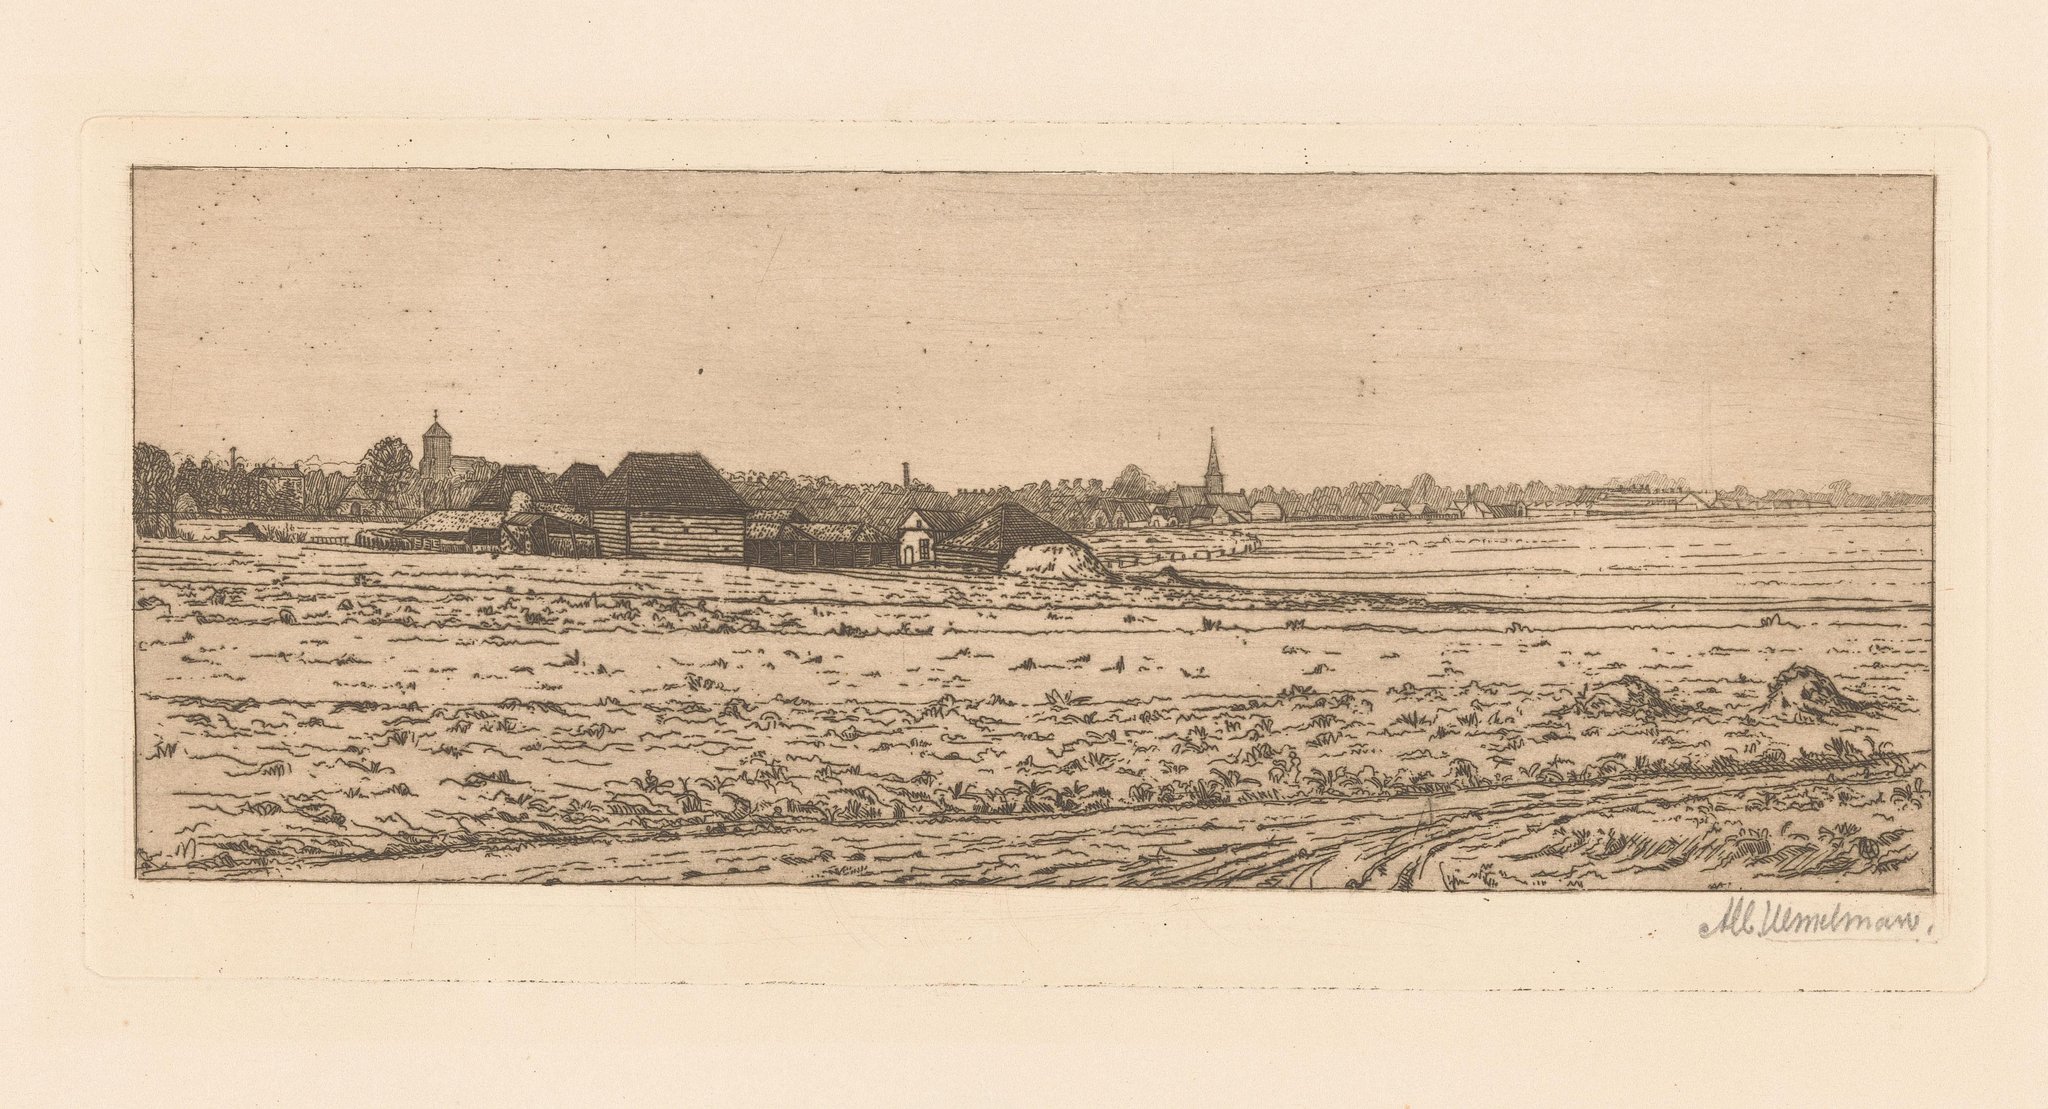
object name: print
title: Boerderij met schuren in een vlak landschap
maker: albert hemelman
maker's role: draughtsman, print maker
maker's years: 1883-1951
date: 1893-1937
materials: paper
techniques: etching, intaglio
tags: prospect of village, silhouette of village, farm or solitary house in landscape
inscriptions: number: ‘6’, collector's mark: Lugt 2760, collector's mark: Lugt 2228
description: Op de achtergrond het silhouet van twee kerktorens.